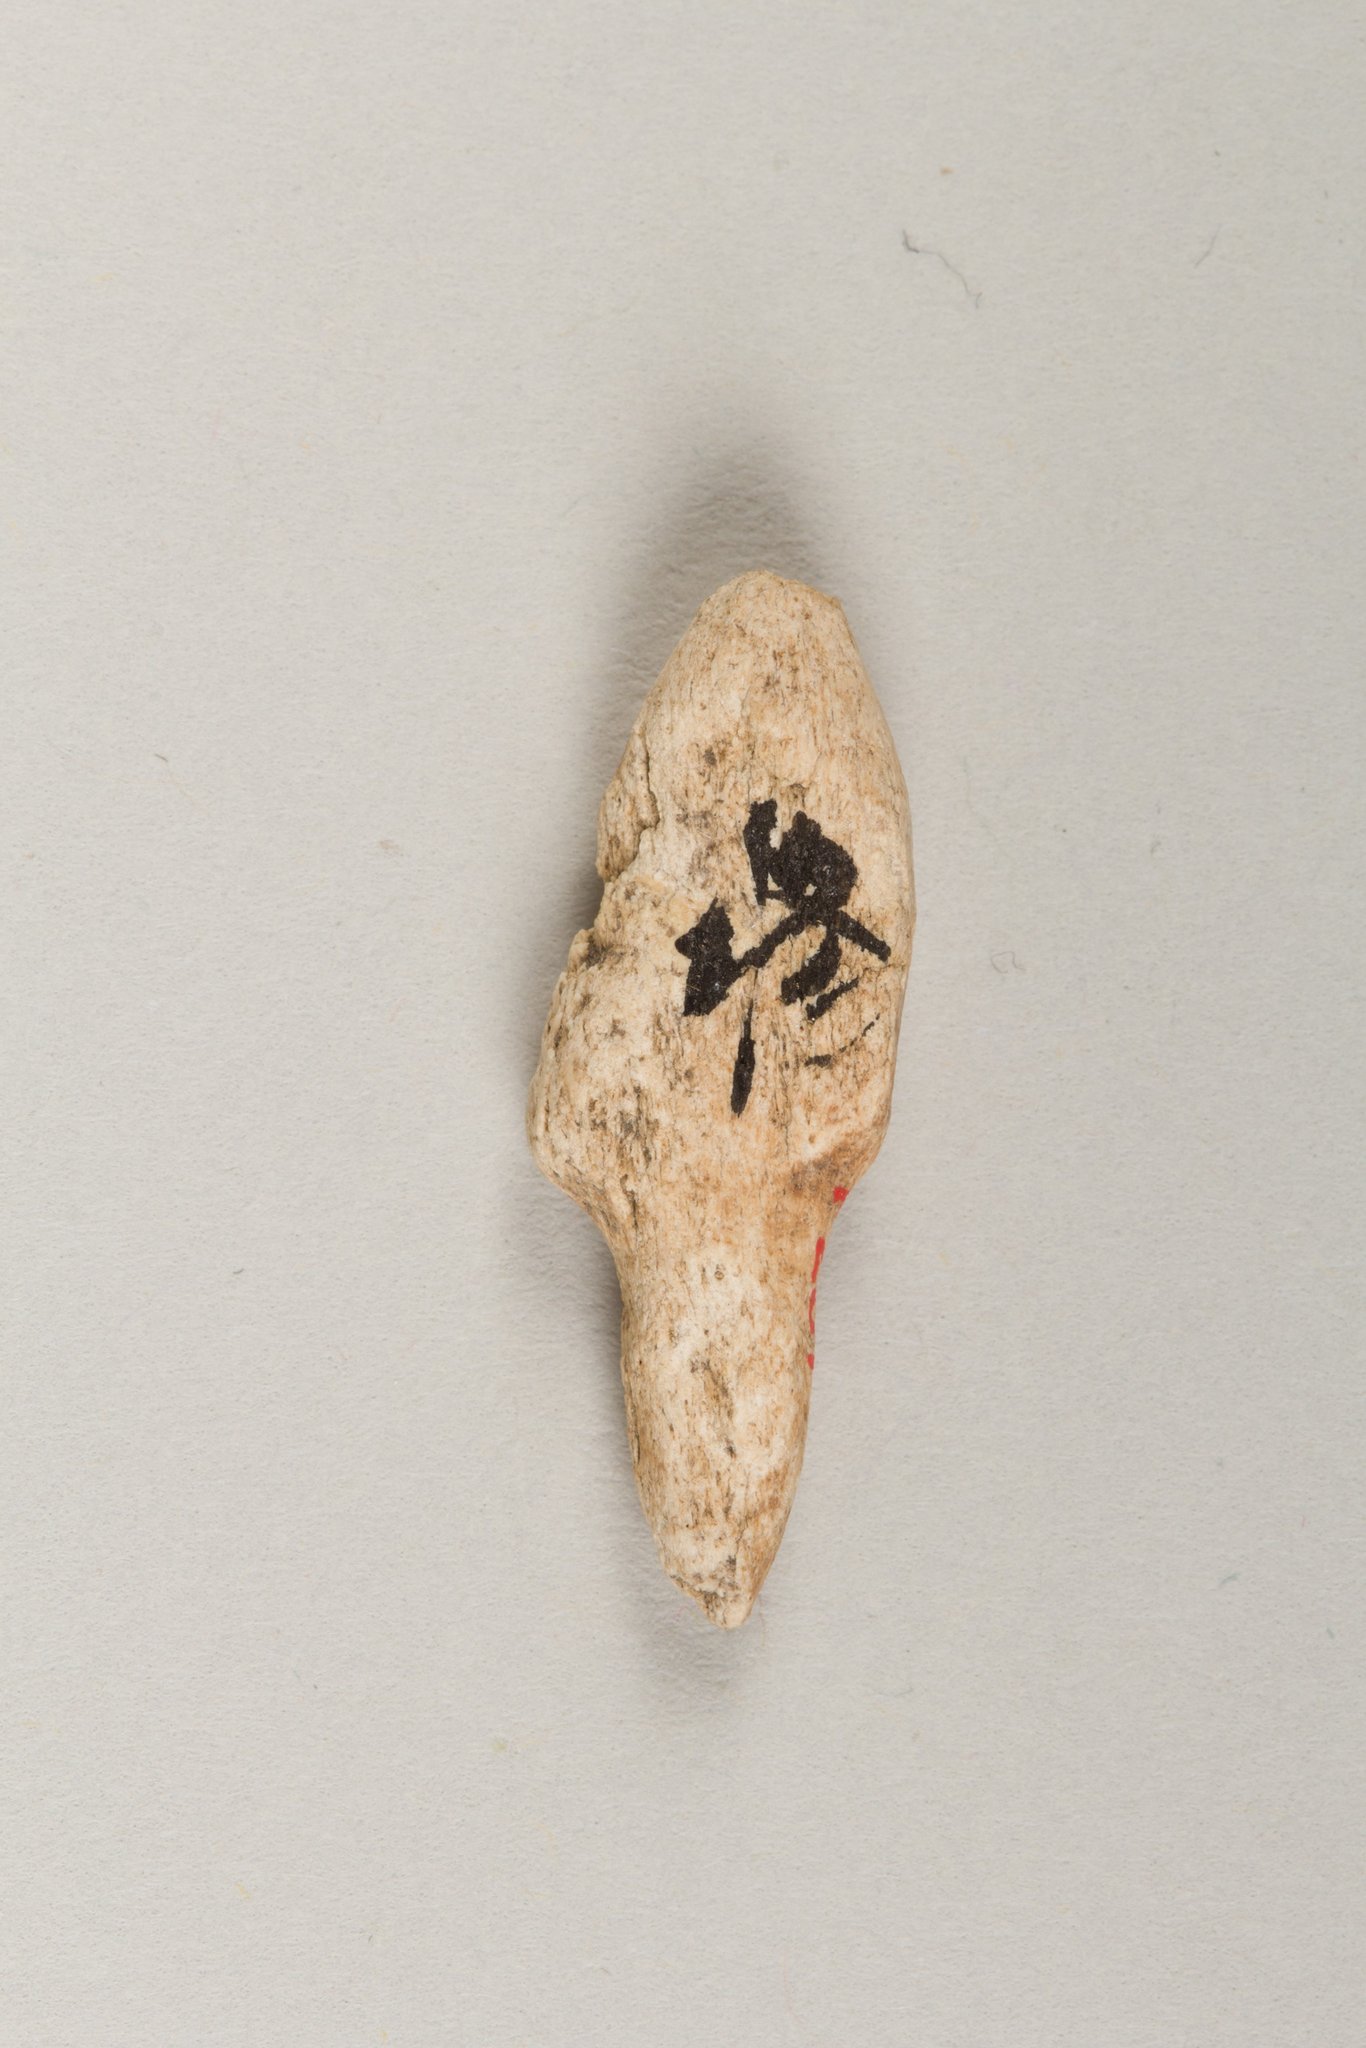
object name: arrowhead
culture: japanese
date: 1000-300 BCE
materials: bone